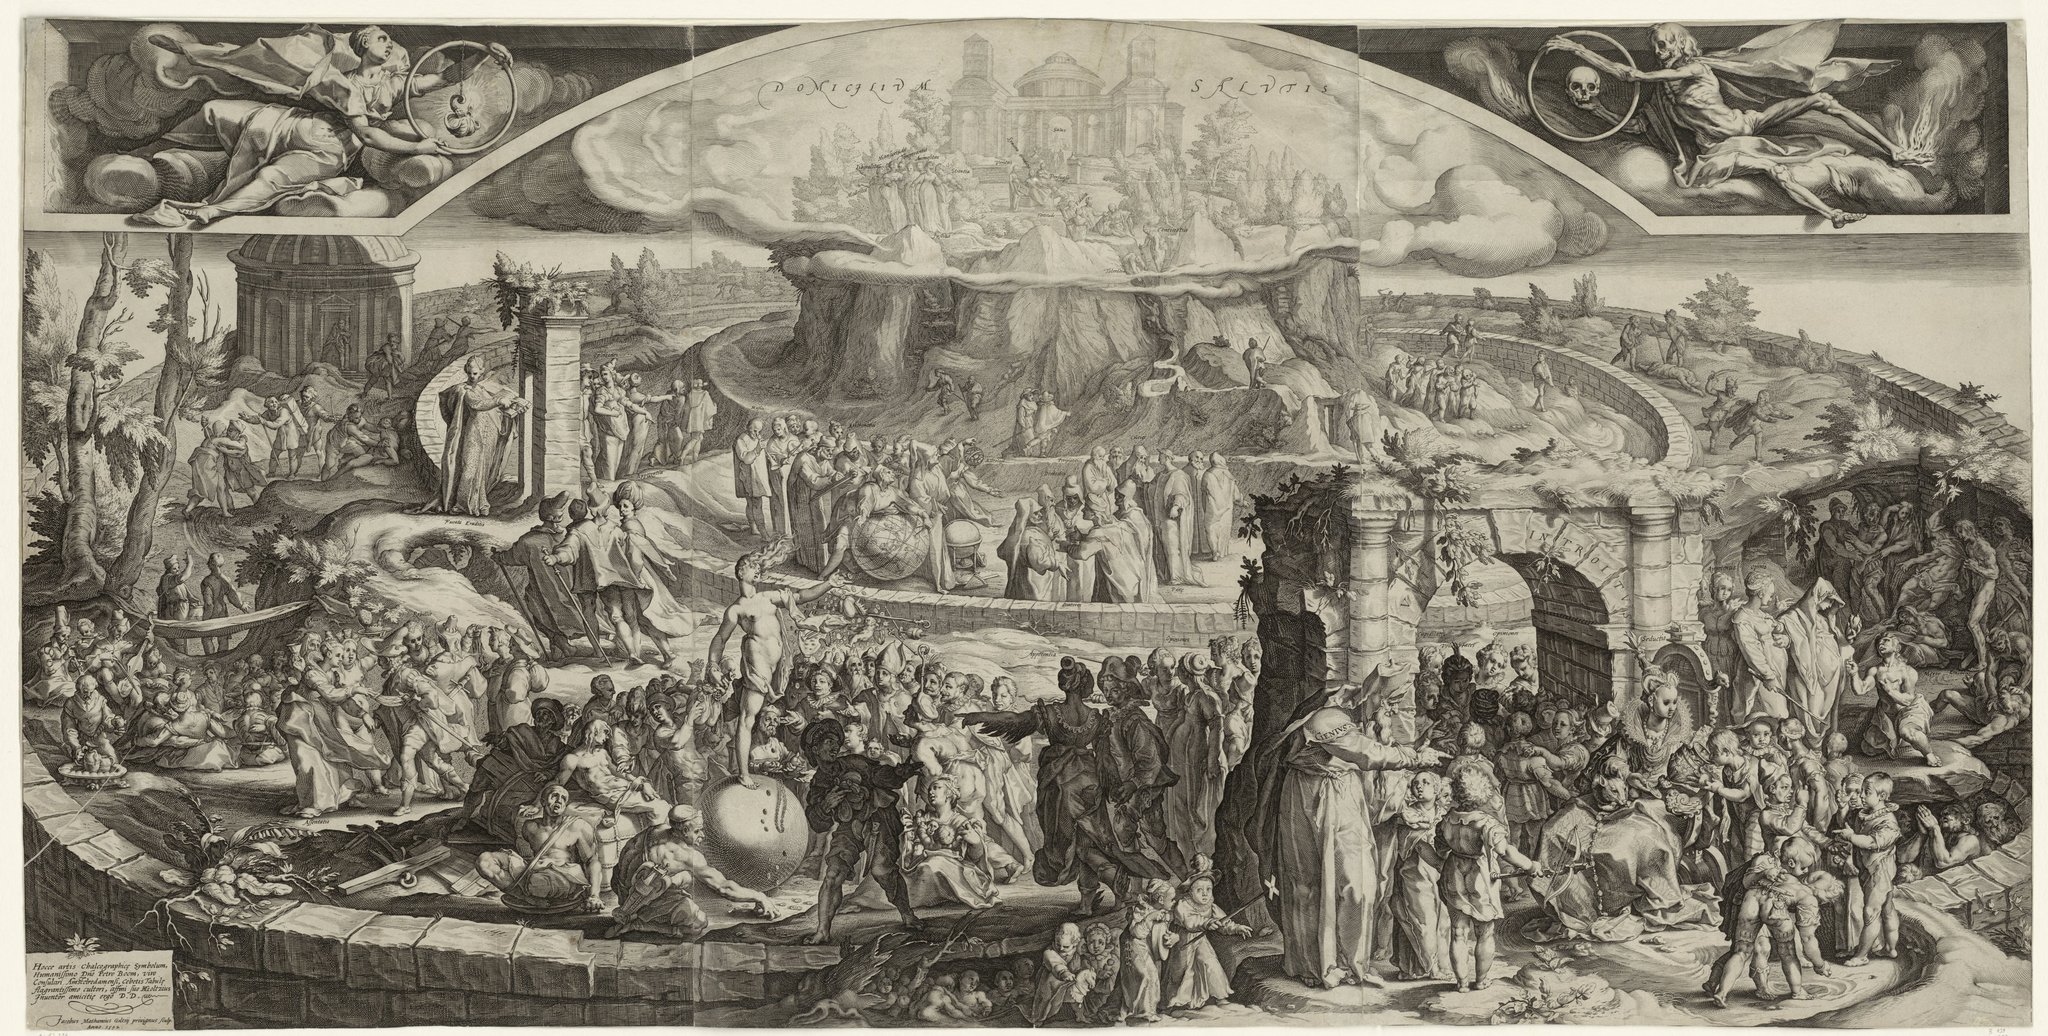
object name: print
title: Exemplaar van de onder RP-P-1887-A-12391 beschreven prent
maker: jacob matham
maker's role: draughtsman, print maker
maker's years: 1571-1631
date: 1581-1631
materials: paper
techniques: engraving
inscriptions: date